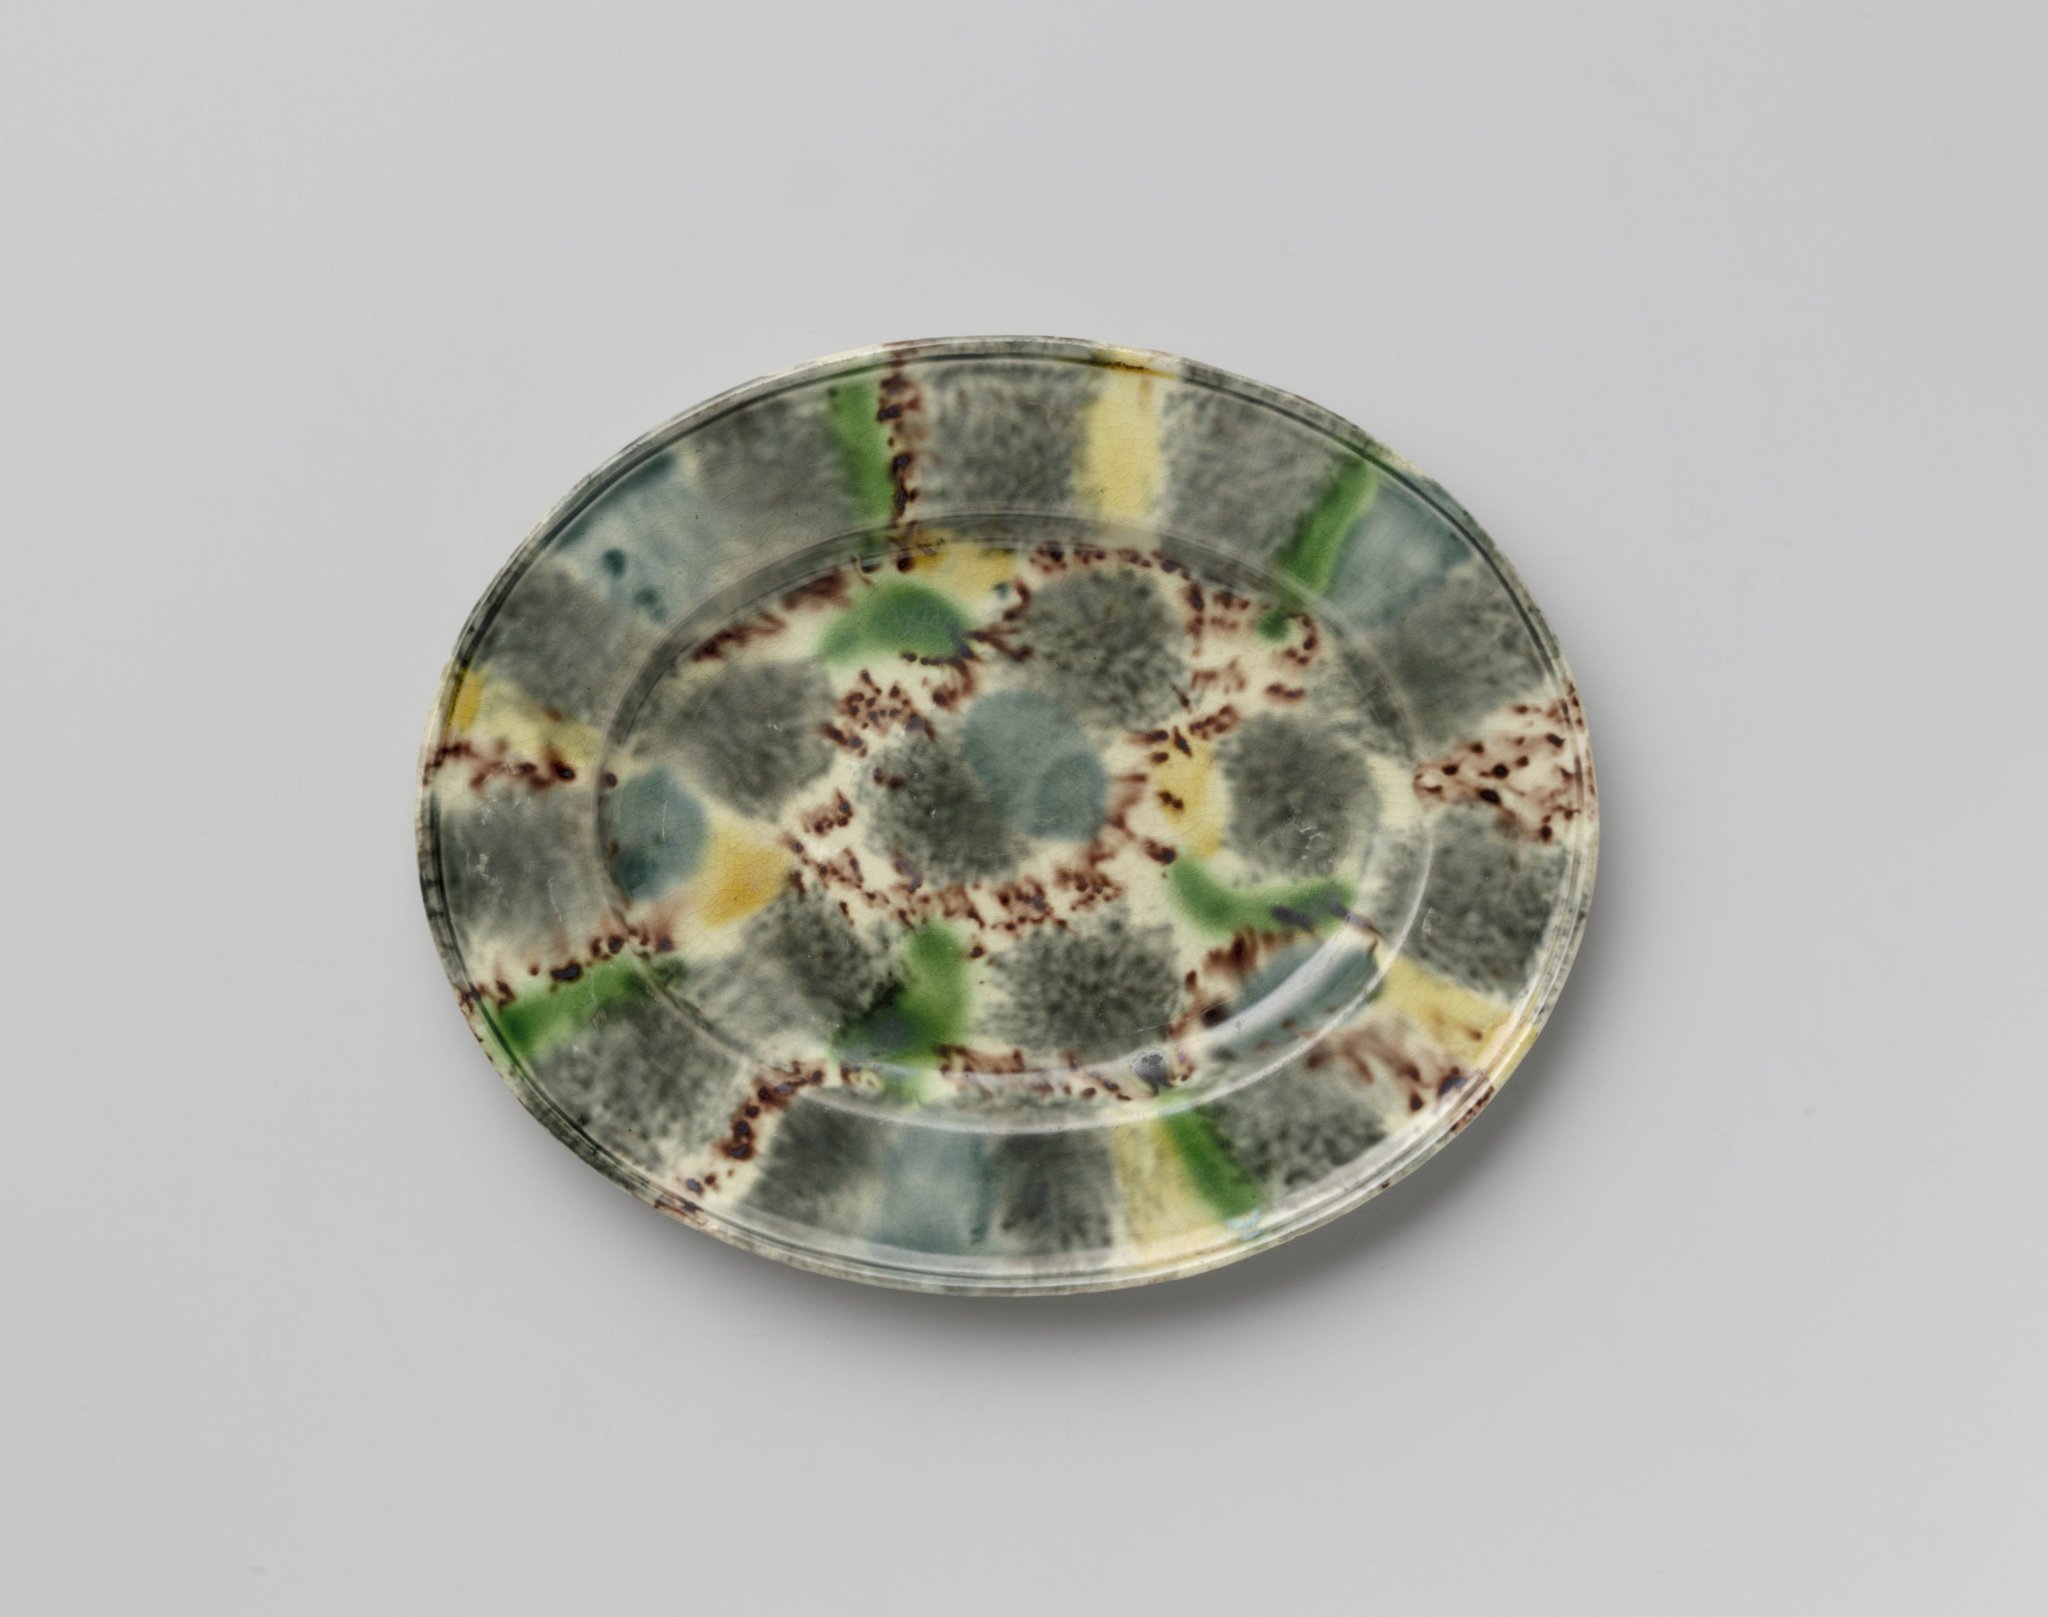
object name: platter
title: Onderschotel van een botervloot, van veelkleurig gebakken aardewerk; Staffordshire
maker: Anonymous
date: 1750-1770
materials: earthenware, glaze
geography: england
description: Onderschotel (ovaal?) van veelkleurig hardgebakken aardewerk. De onderschotel is gedecoreerd met gevlekte loodglazuur in de kleuren blauw, grijs, groen en geel met een mangane stippeling. De onderkant van de schotel is in mangaan gestippeld. De onderschotel hoort bij een botervloot die ontbreekt en een deksel (BK-1987-36-D).